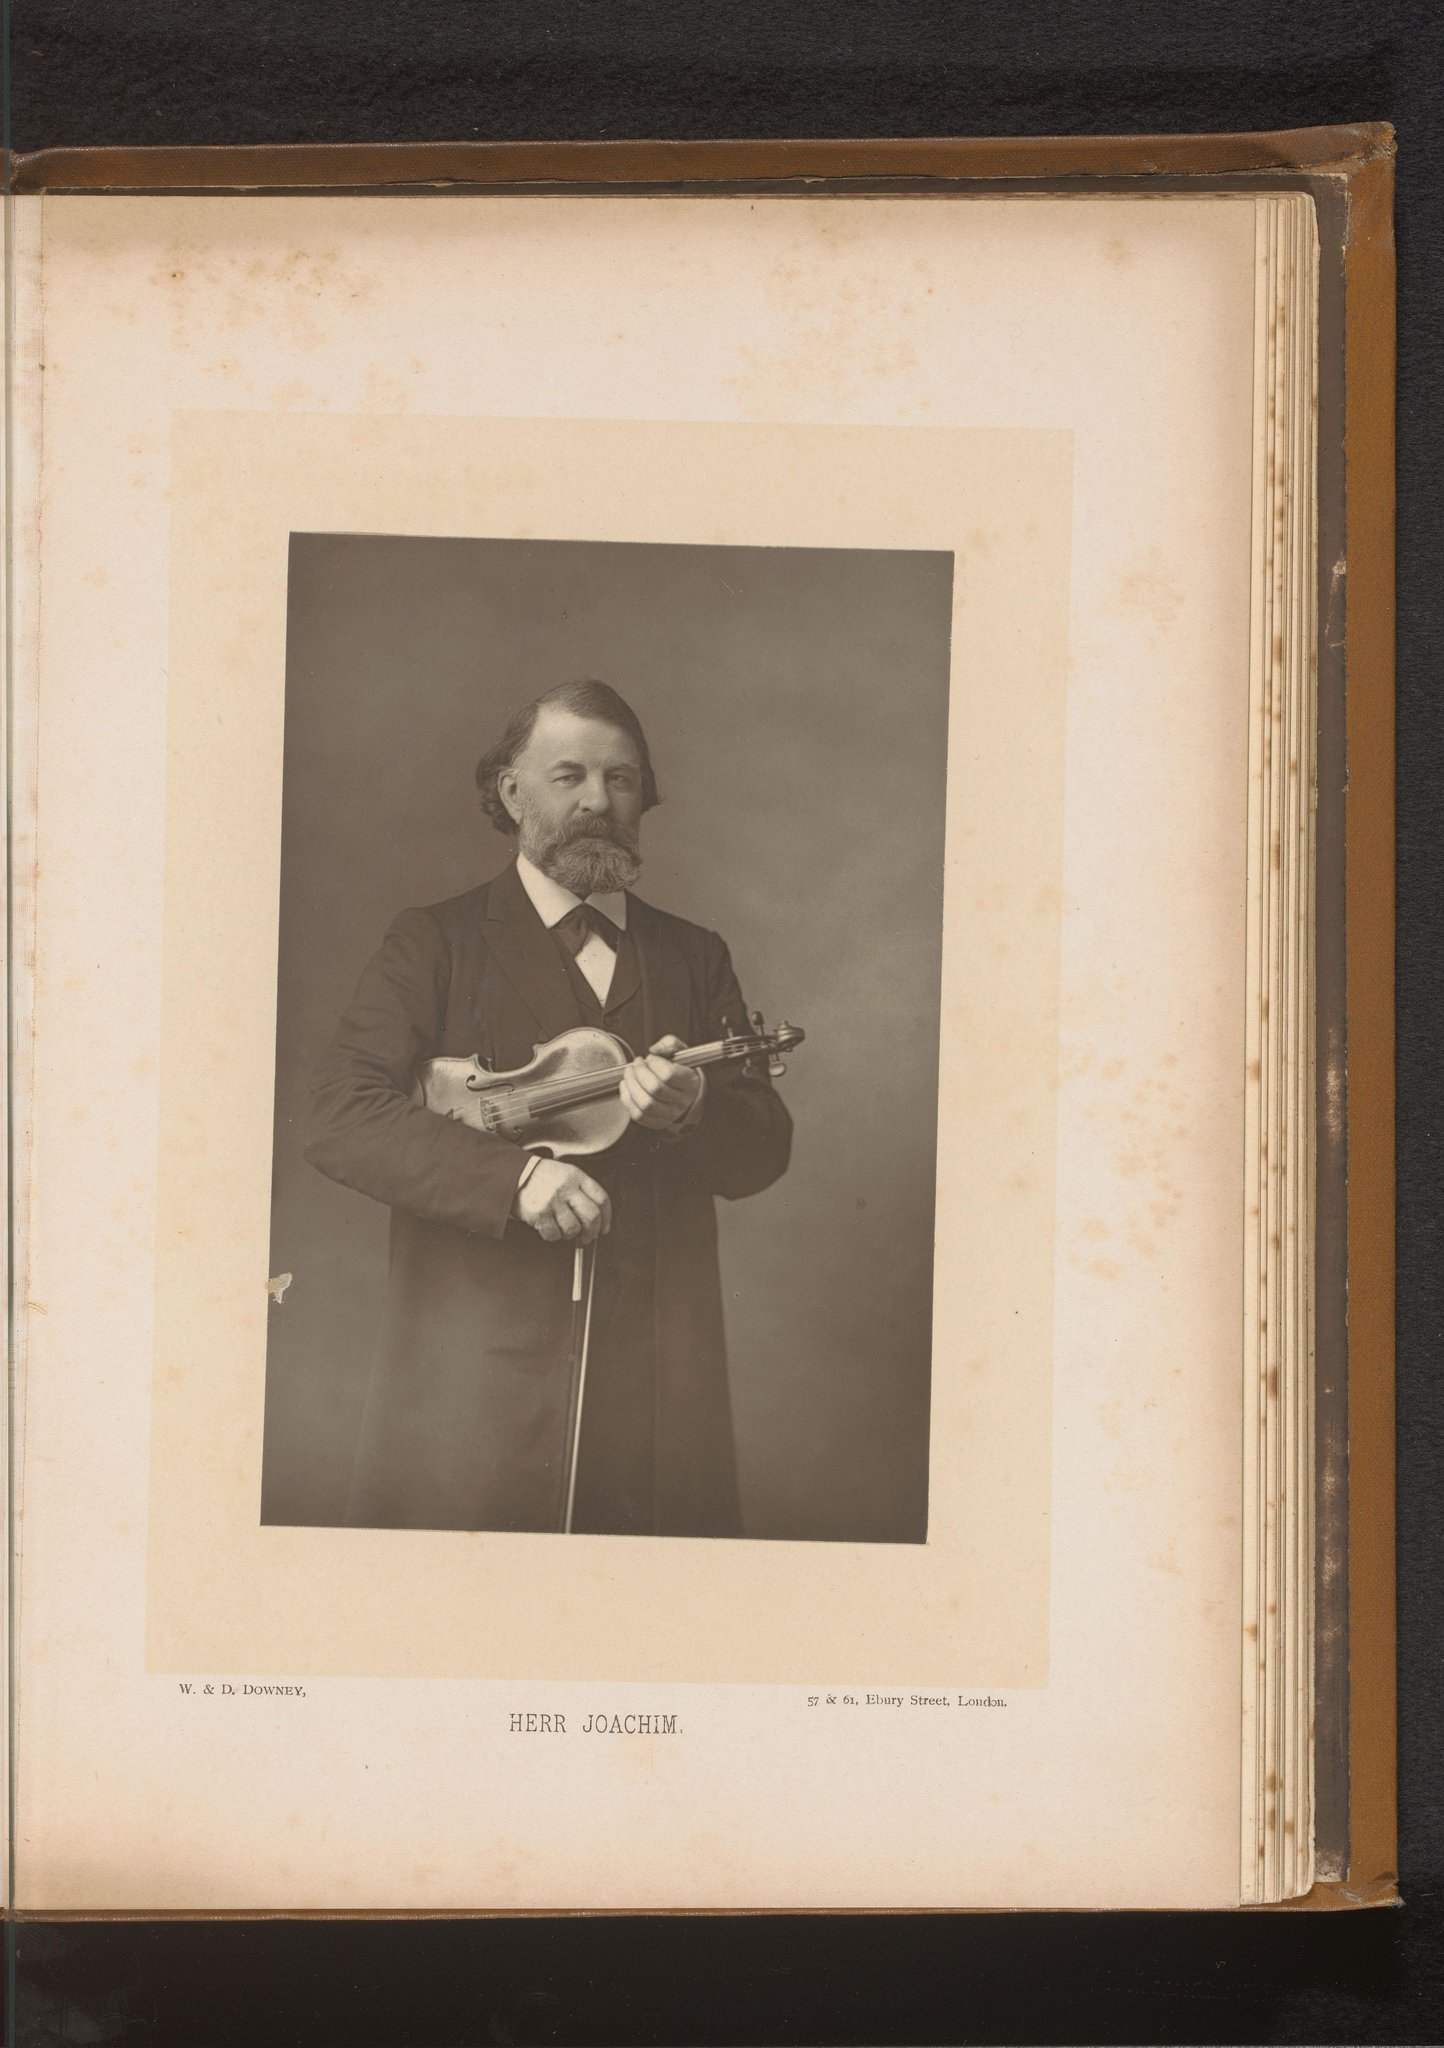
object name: page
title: Herr Joachim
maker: Anonymous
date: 1880-1890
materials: paper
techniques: woodburytype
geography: london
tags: musician, portrait of a musician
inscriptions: inscription: ‘57 & 61, Elbury Street, London.’